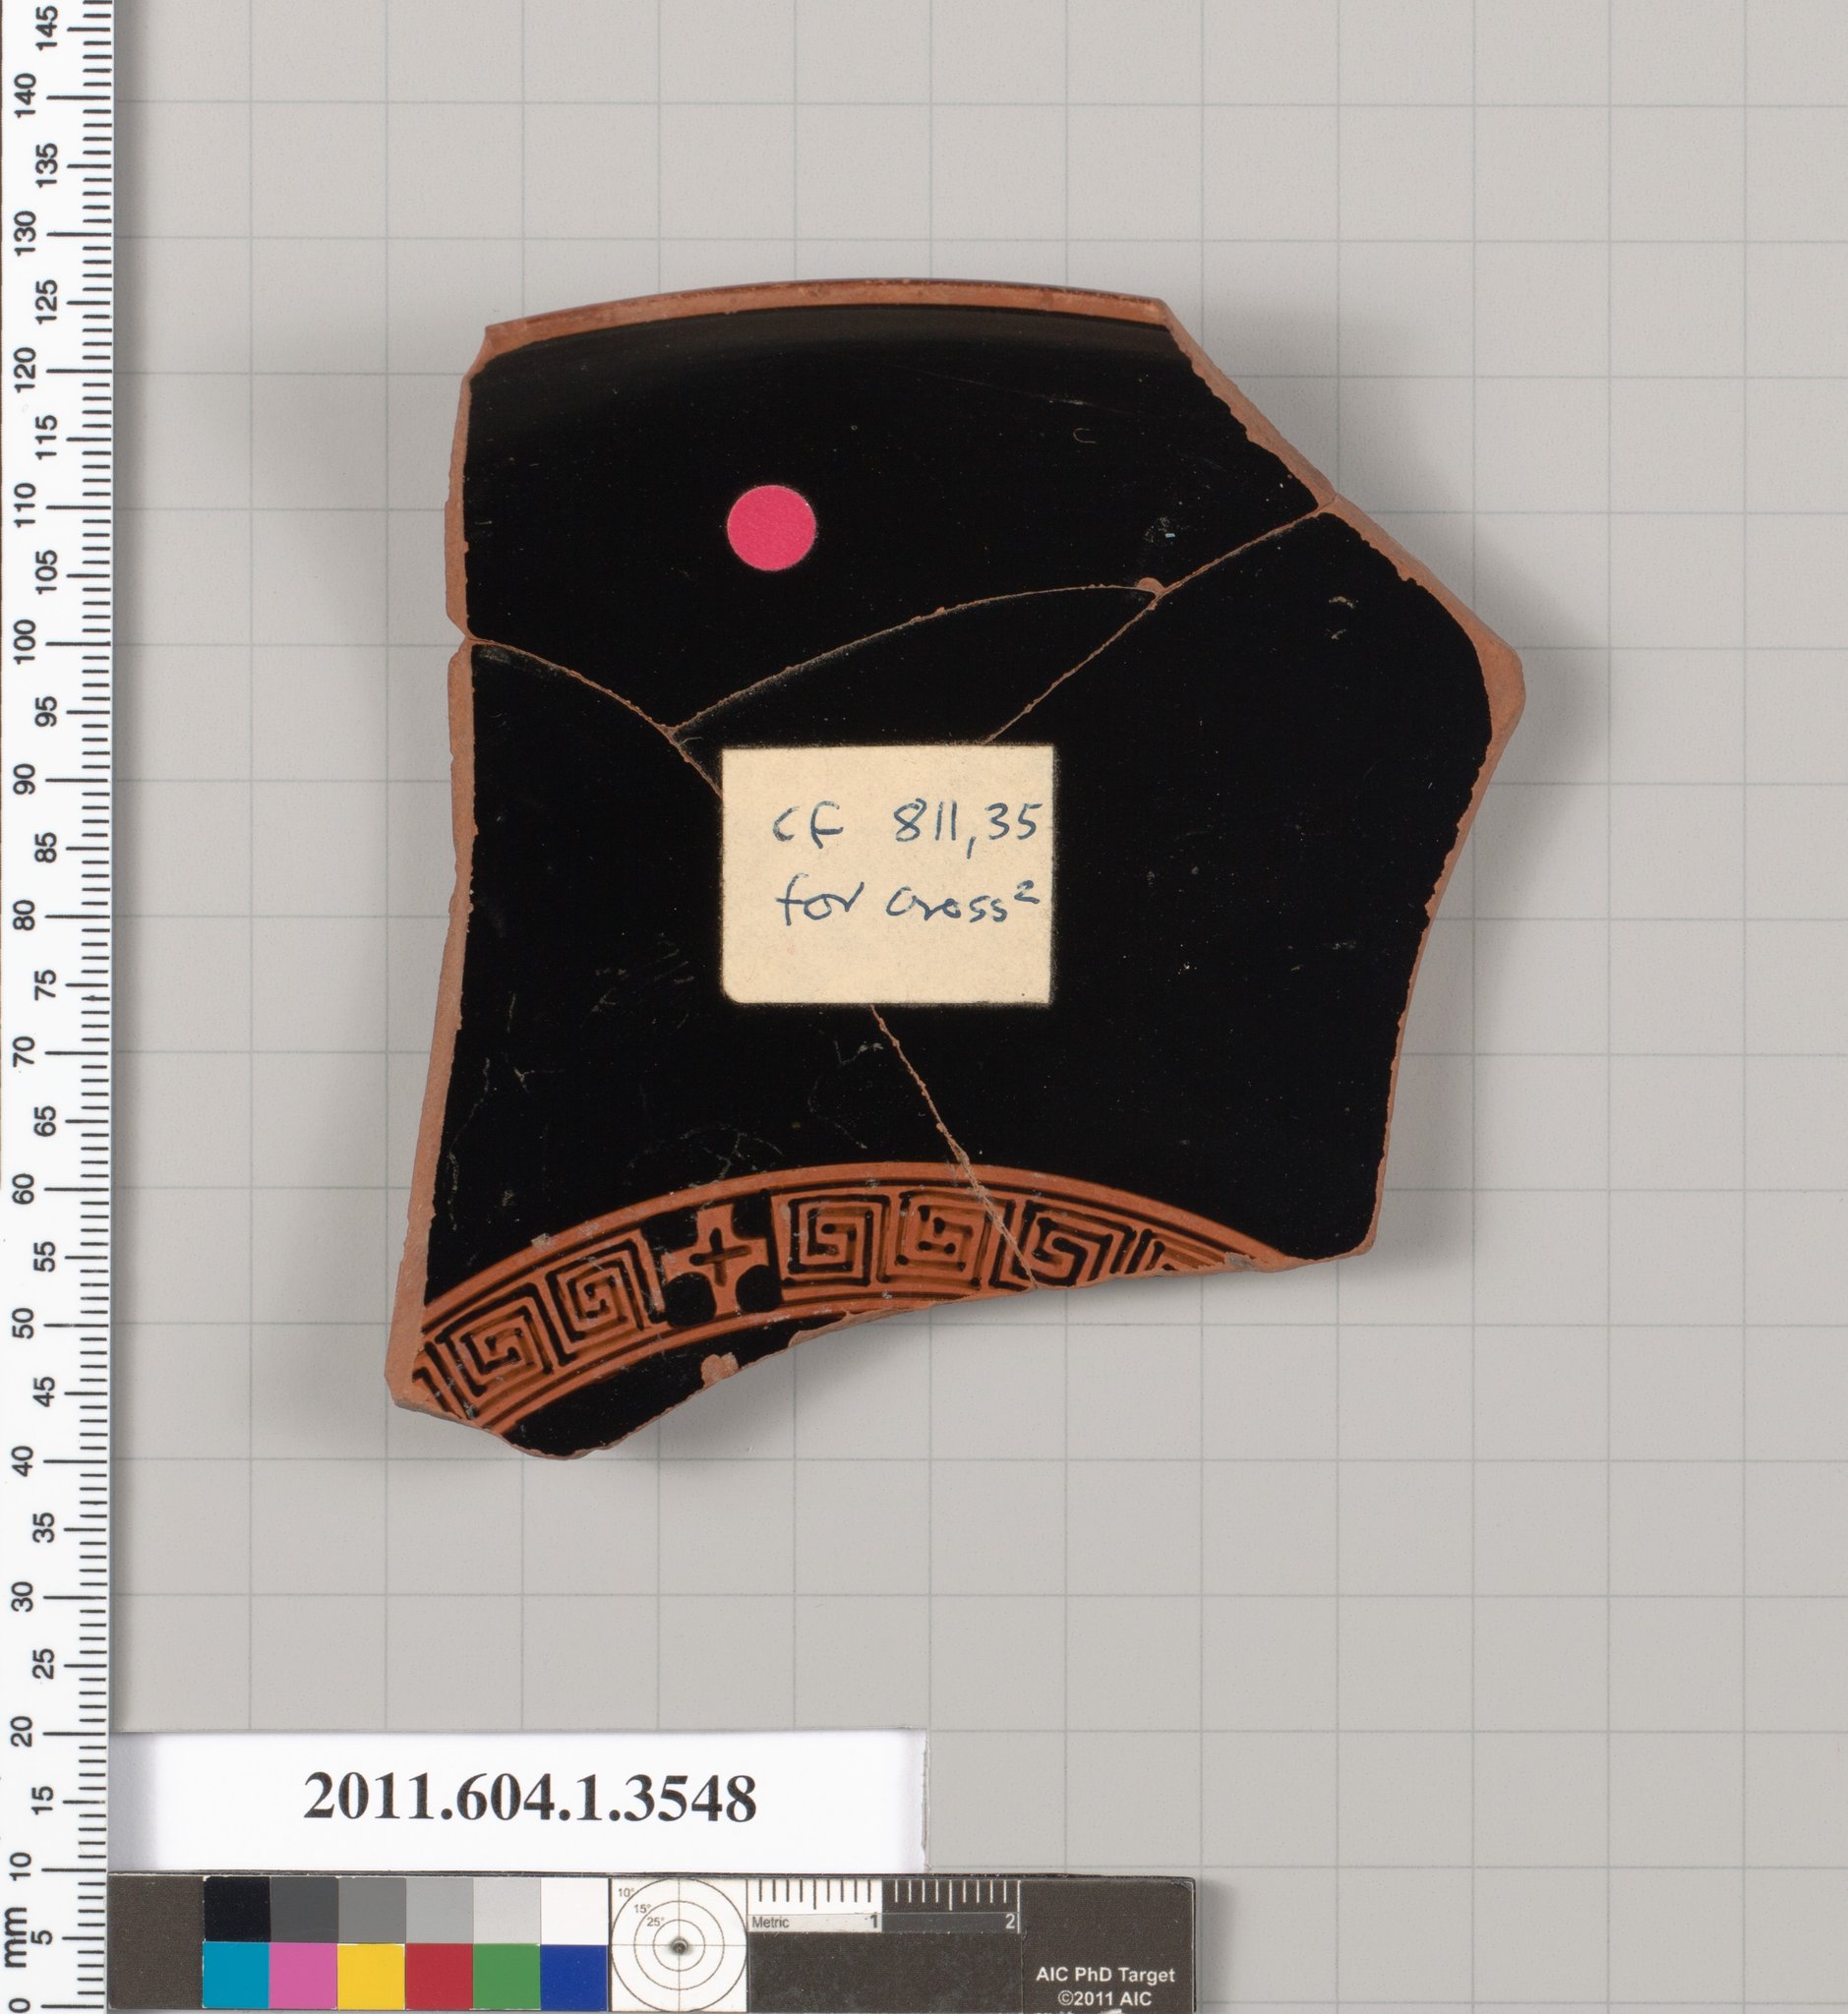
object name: kylix fragment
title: Terracotta rim fragment of a kylix (drinking cup)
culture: greek, attic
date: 480-470 BCE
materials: terracotta